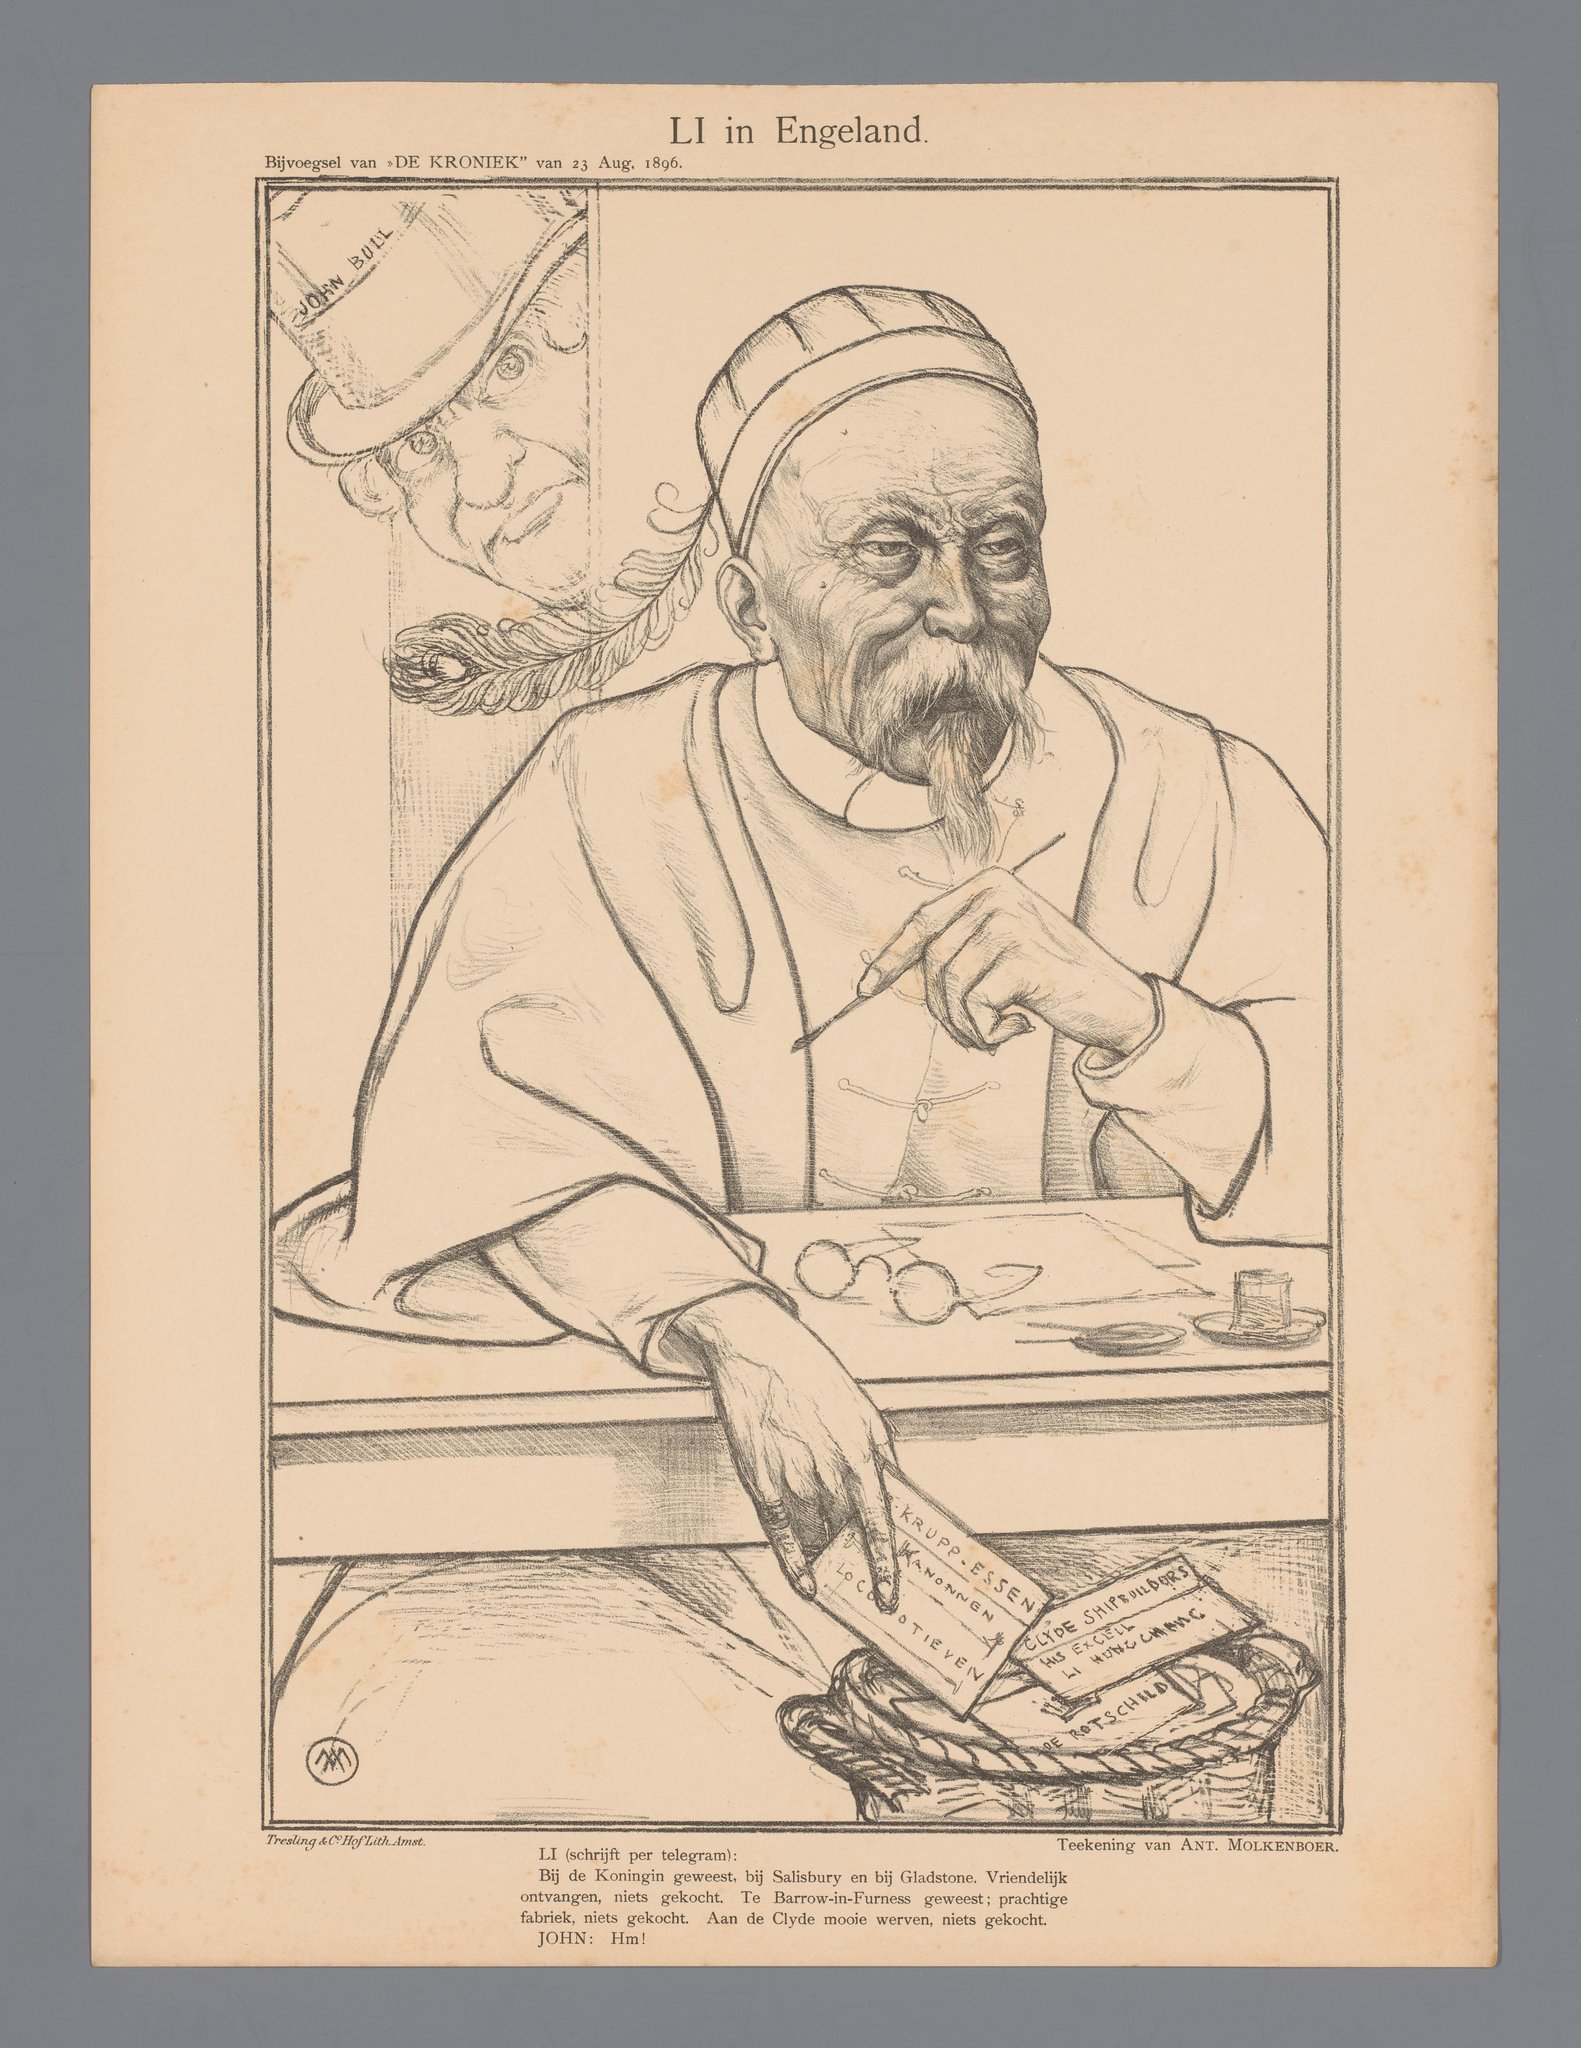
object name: cartoon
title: LI in Engeland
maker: anton molkenboer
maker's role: print maker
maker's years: 1872-1960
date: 1896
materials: paper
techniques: lithograph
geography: amsterdam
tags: politician, old man, political caricatures and satires, china, england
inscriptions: date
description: Prent uit het bijvoegsel van: De Kroniek 2 (1896), 23 augustus 1896.